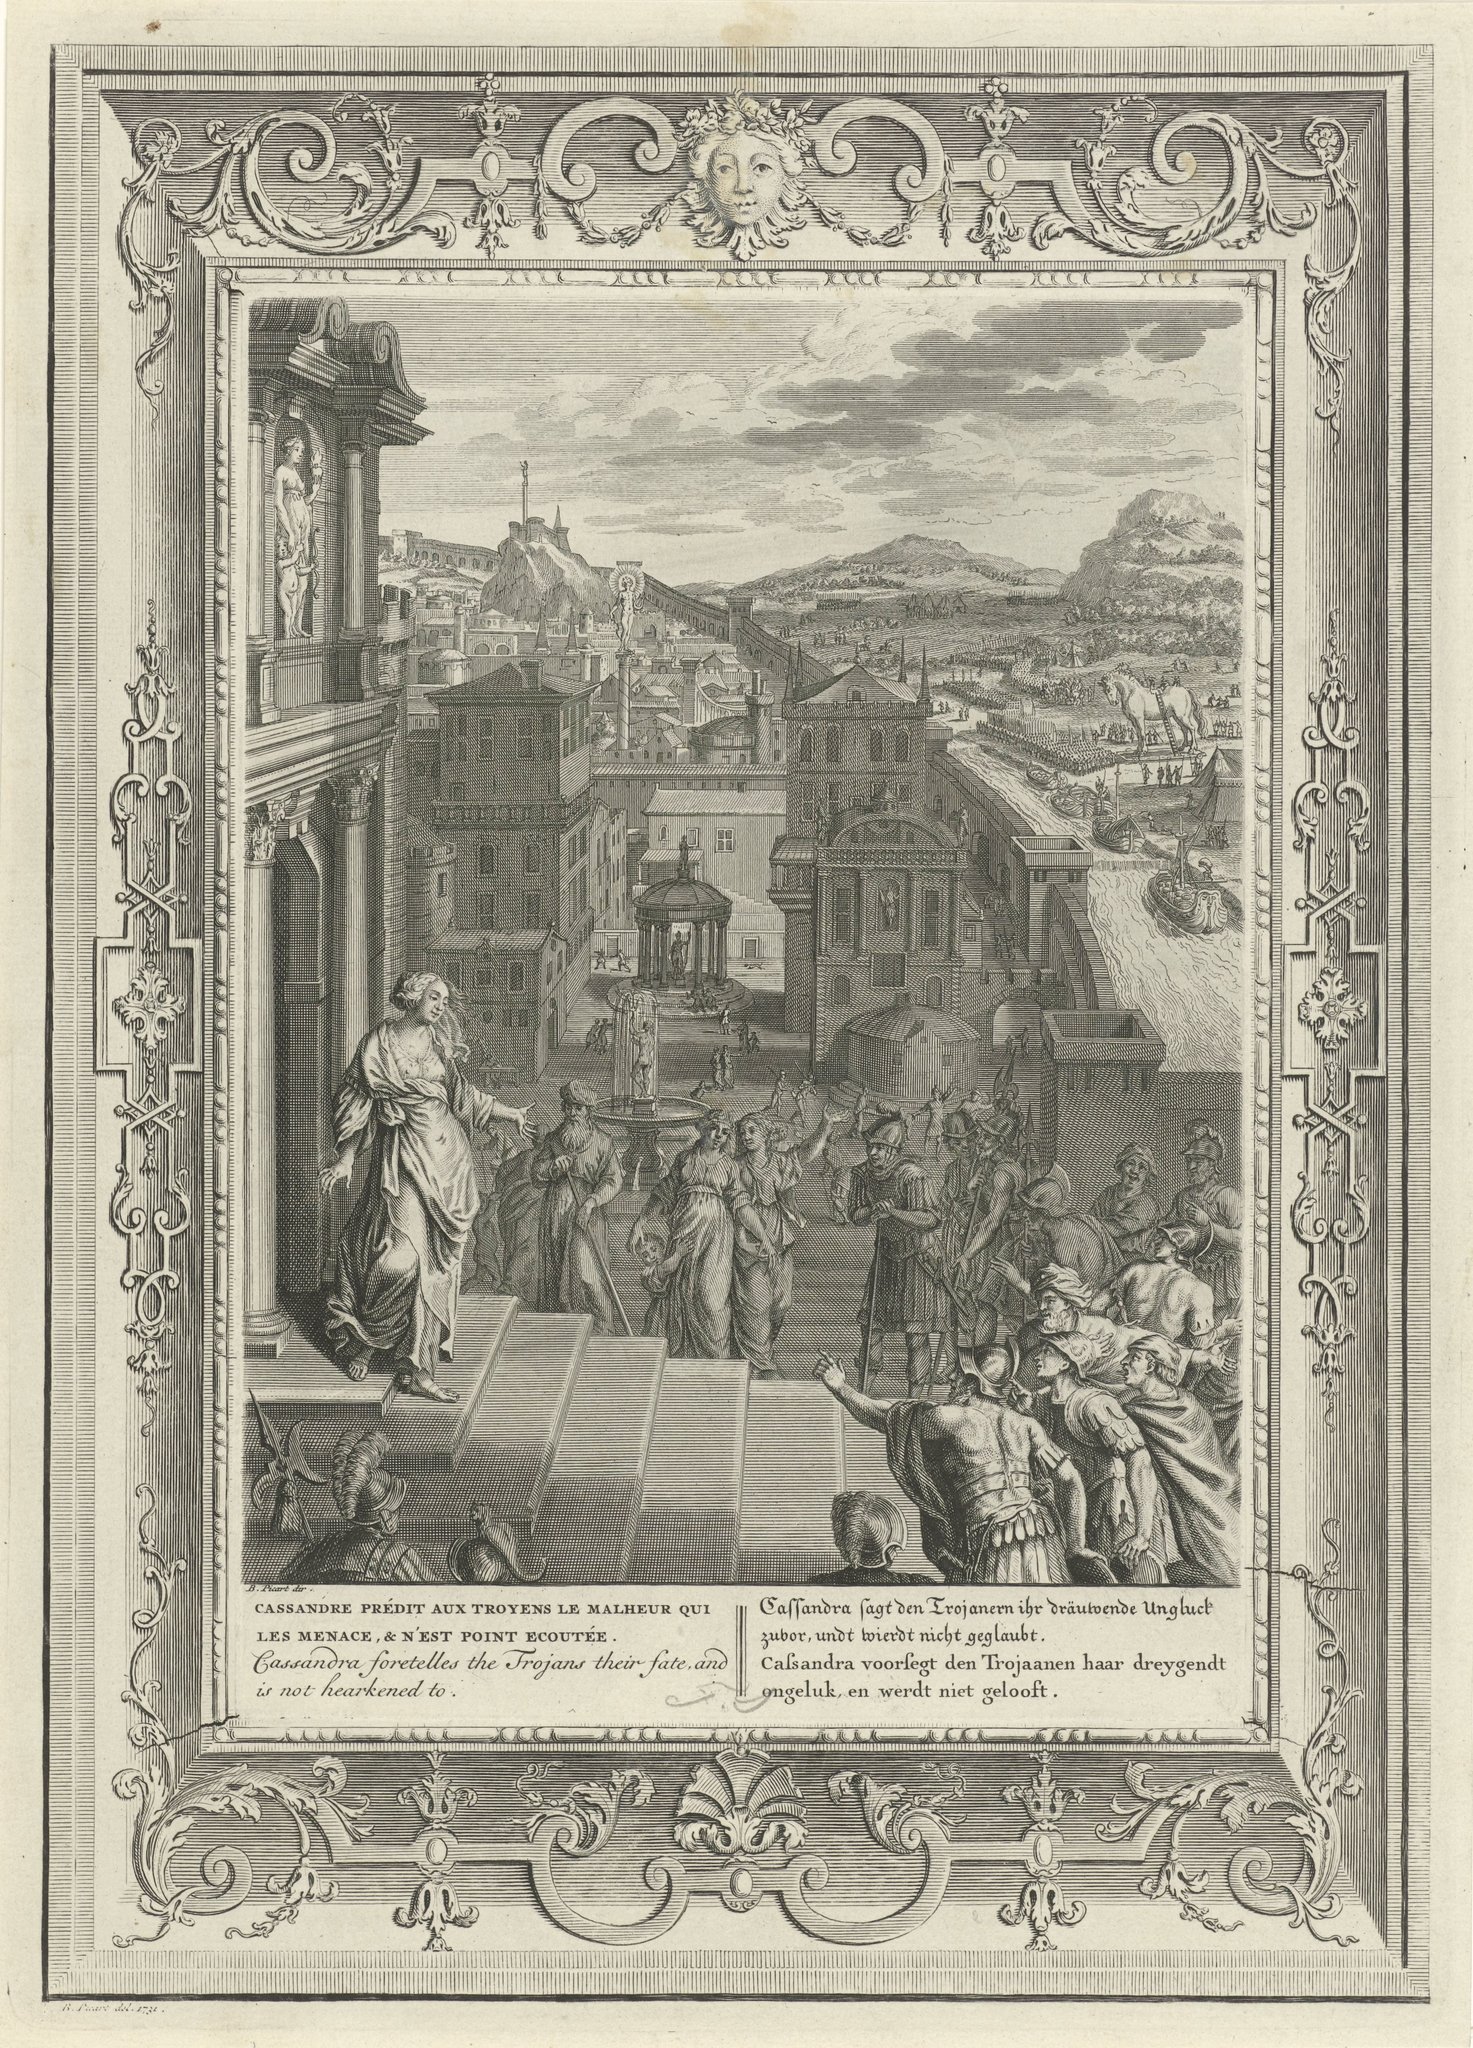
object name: print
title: Cassandra voorspelt de ondergang van Troje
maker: bernard picart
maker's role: draughtsman, print maker, publisher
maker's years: 1673-1733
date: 1731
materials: paper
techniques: engraving, etching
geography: amsterdam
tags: the trojan horse, cassandra prophesying, scrollwork, strapwork ~ ornament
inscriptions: collector's mark: Lugt 2228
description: Cassandra, de dochter van koning Priamus, voorspelt de ondergang van Troje maar wordt door niemand geloofd. Rechts op de achtergrond het paard van Troje, dat de stad binnen gevoerd zal worden. In de marge de titel in het Frans, Engels, Duits en Nederlands. De voorstelling is gedecoreerd met een ornamentele rand.